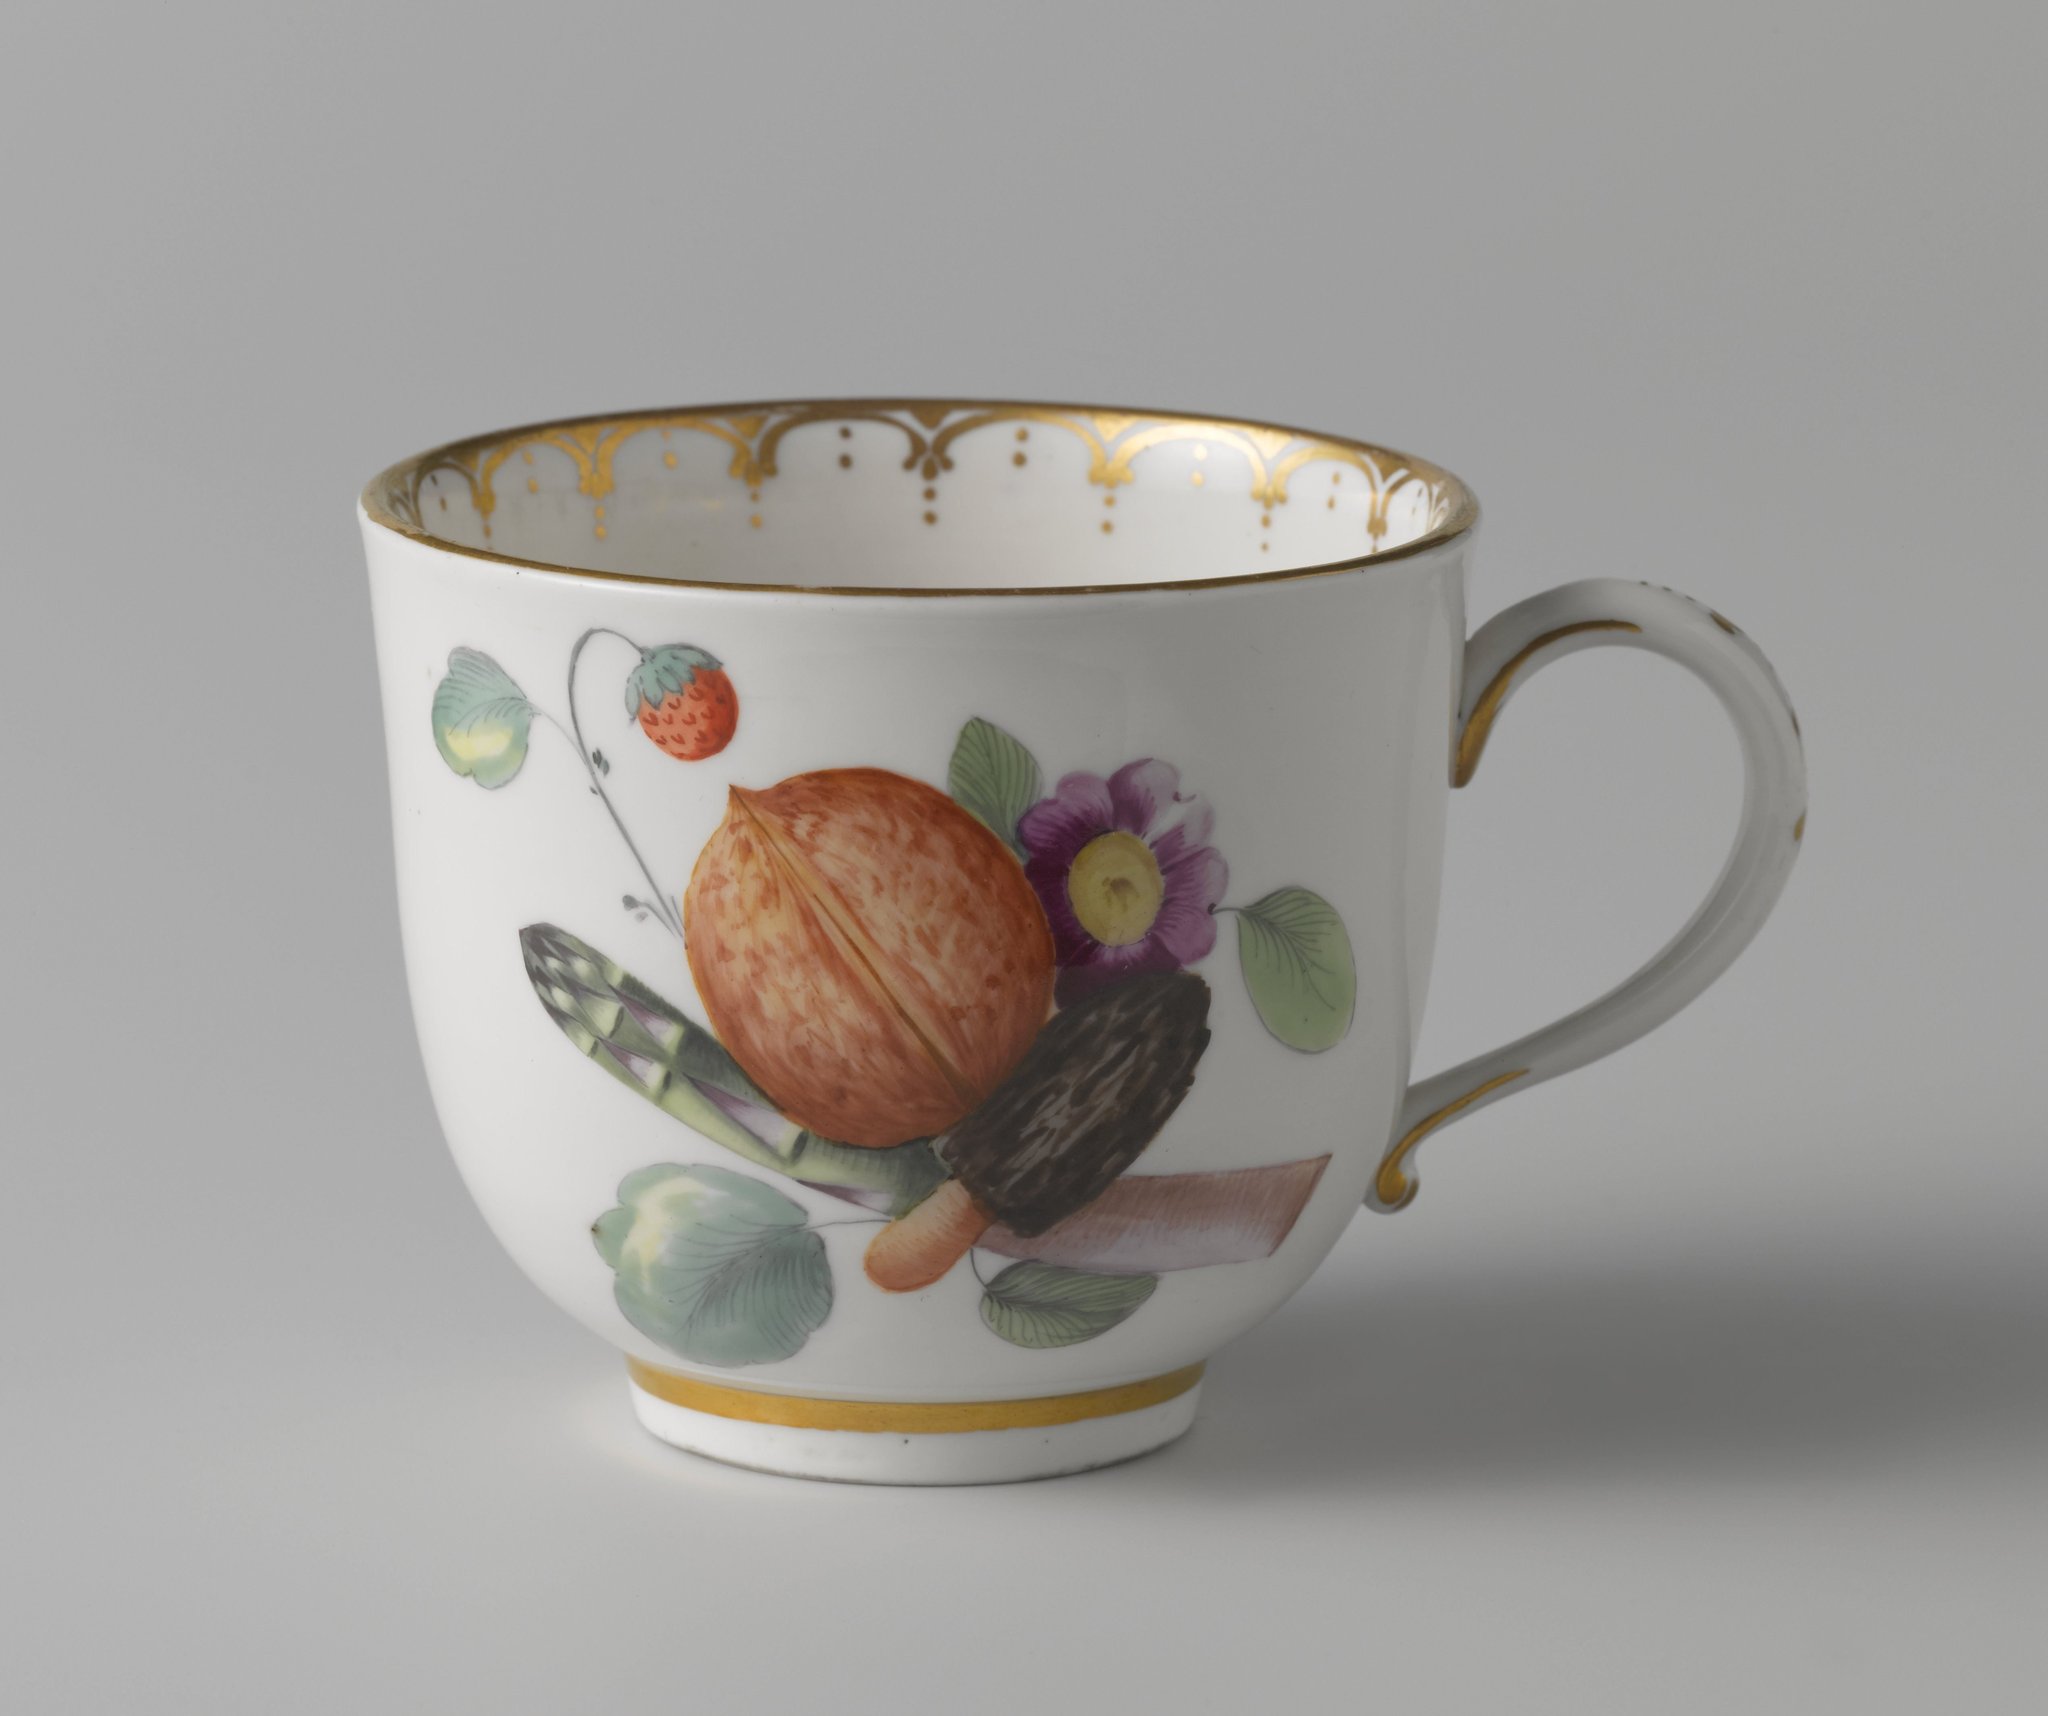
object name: cup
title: Cup and saucer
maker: Anonymous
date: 1777-1790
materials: porcelain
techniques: painted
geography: the hague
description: Ansbach painted decoration: Porseleinfabriek Den Haag, 1777â€“1790 hard-paste porcelain